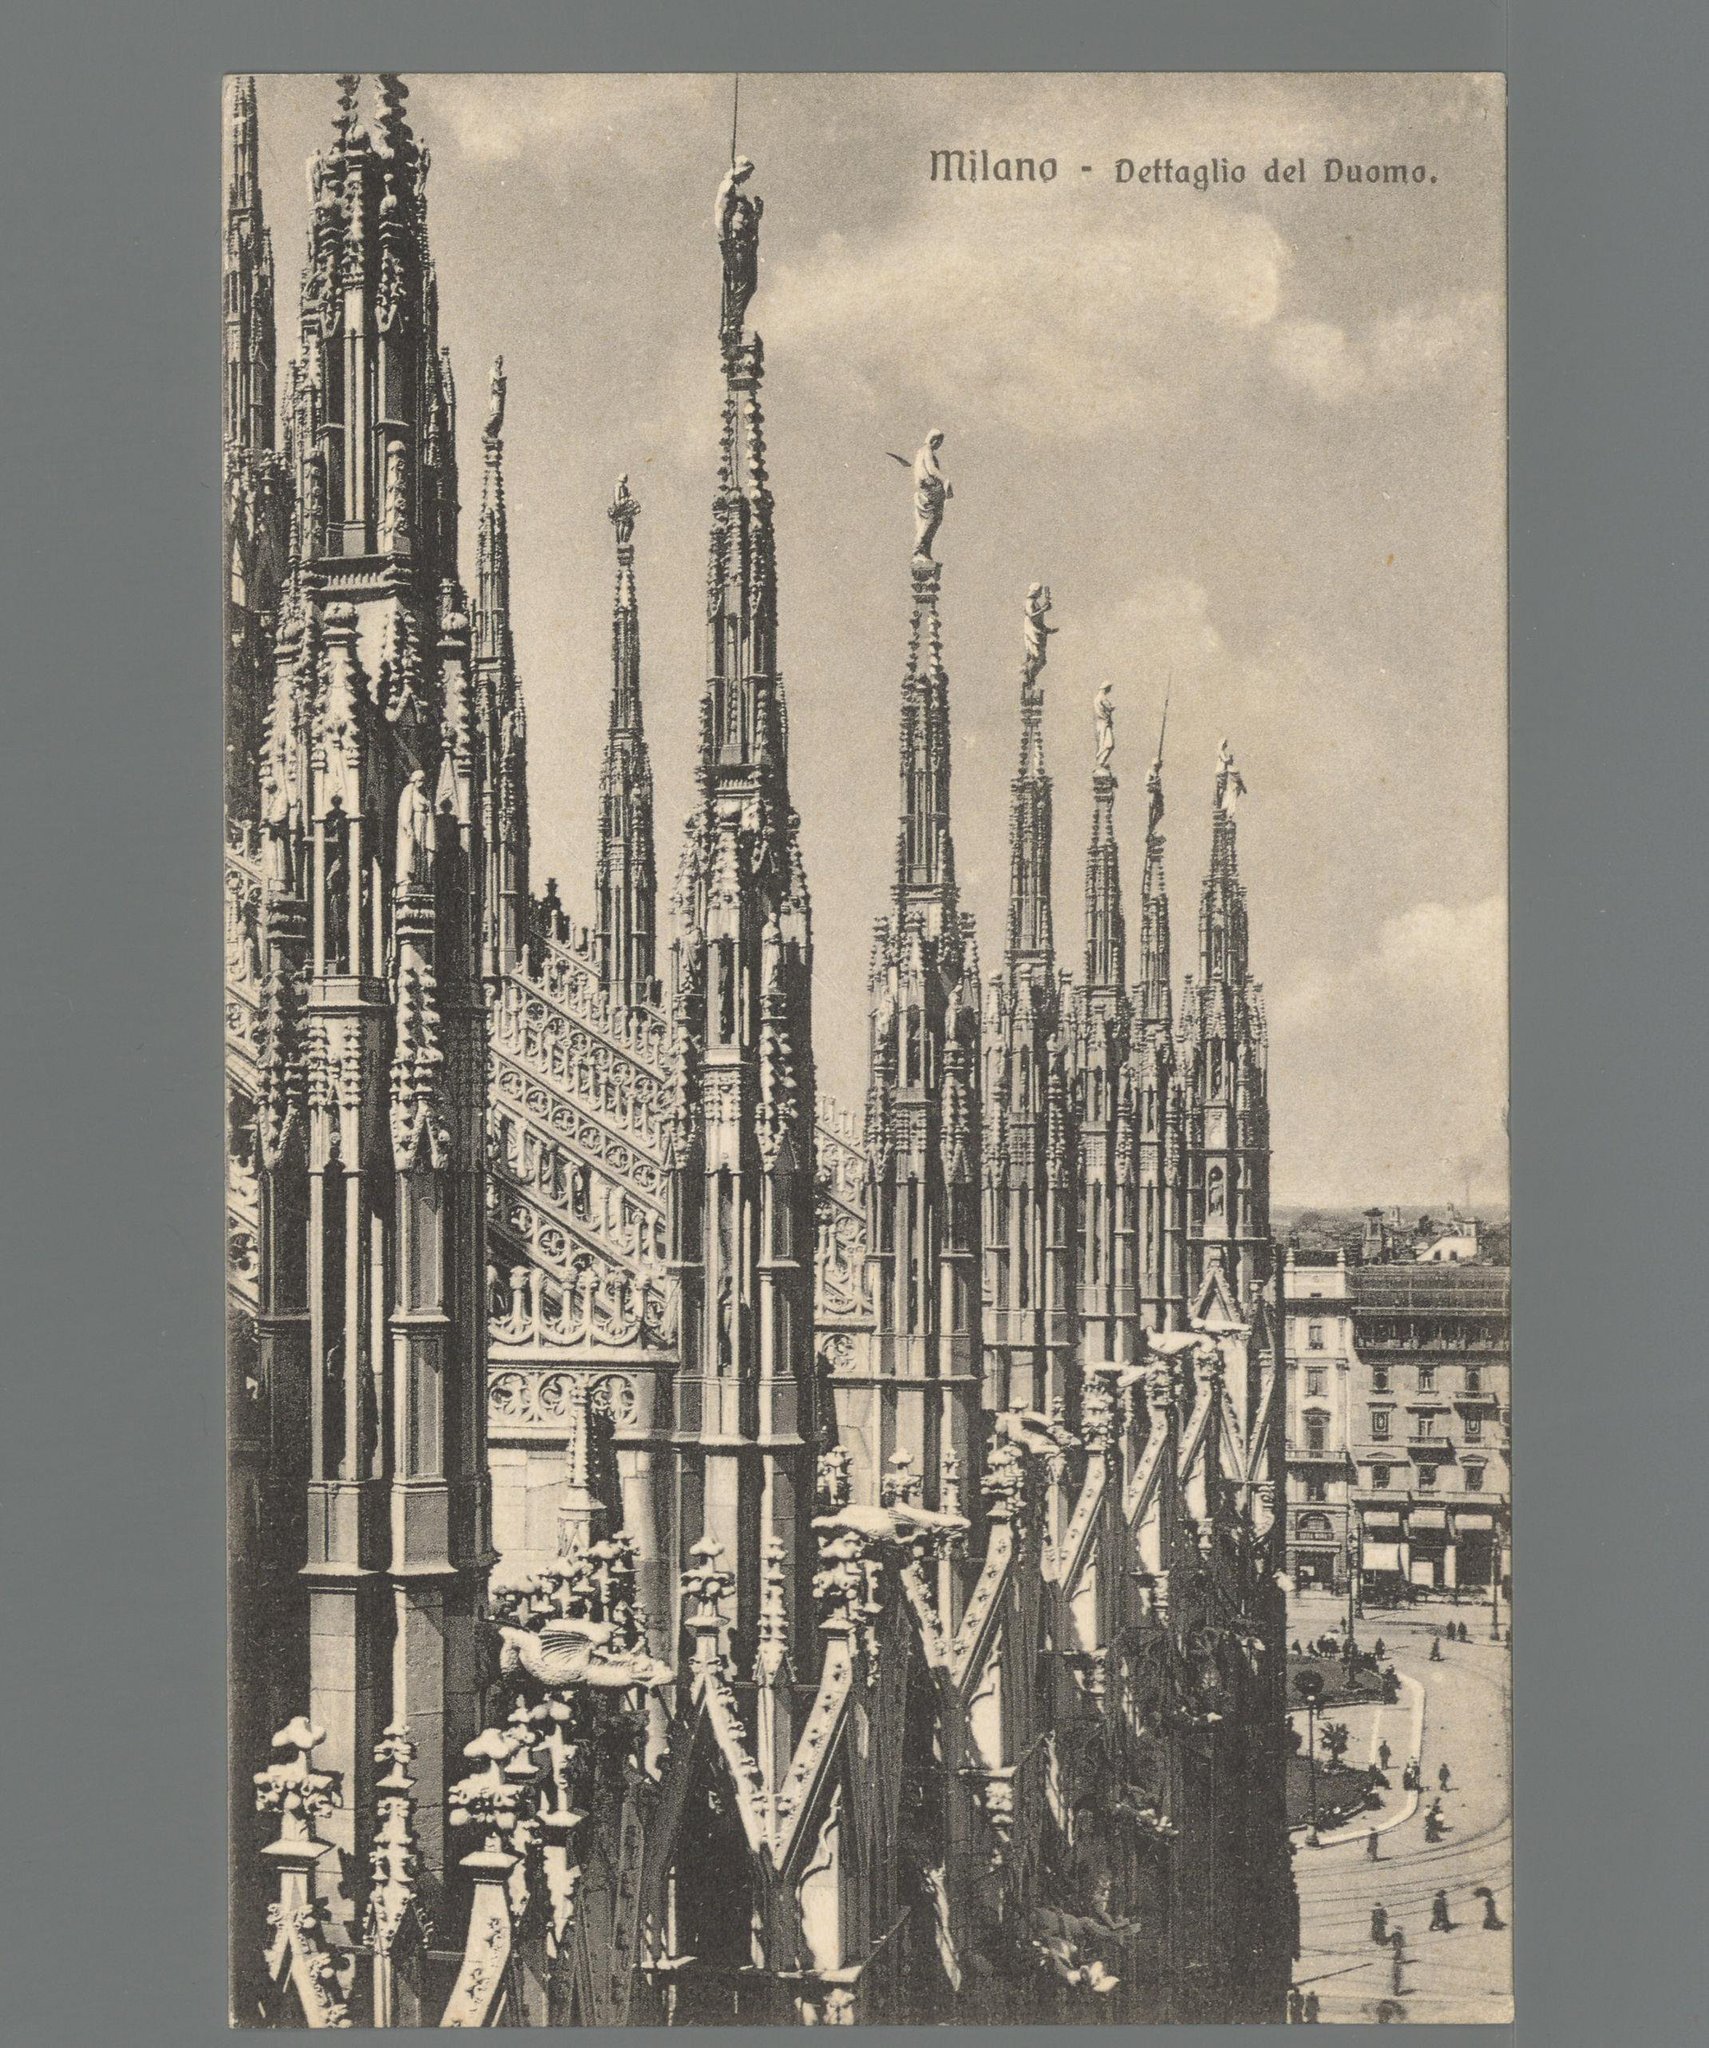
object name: ansichtkaart, prentbriefkaart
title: Milano. Dettaglio del Duomo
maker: Anonymous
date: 1905-1920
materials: cardboard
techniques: photograph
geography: como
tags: church (exterior), city-view, and landscape with man-made constructions (+ city(-scape) with figures, staffage)